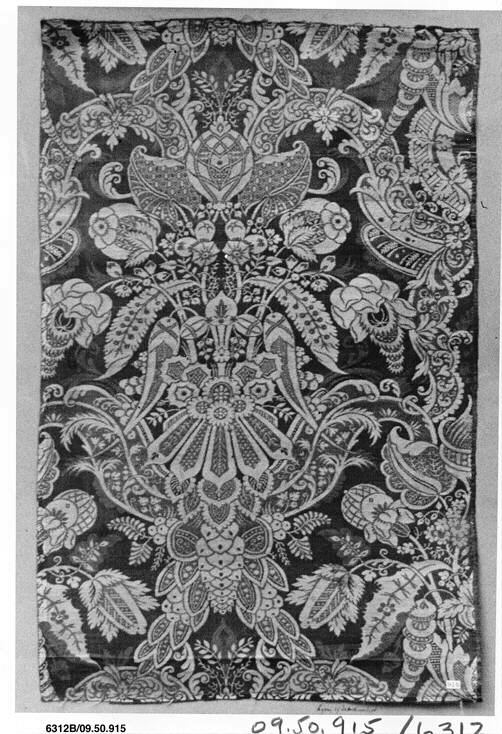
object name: piece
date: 1720-1725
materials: silk